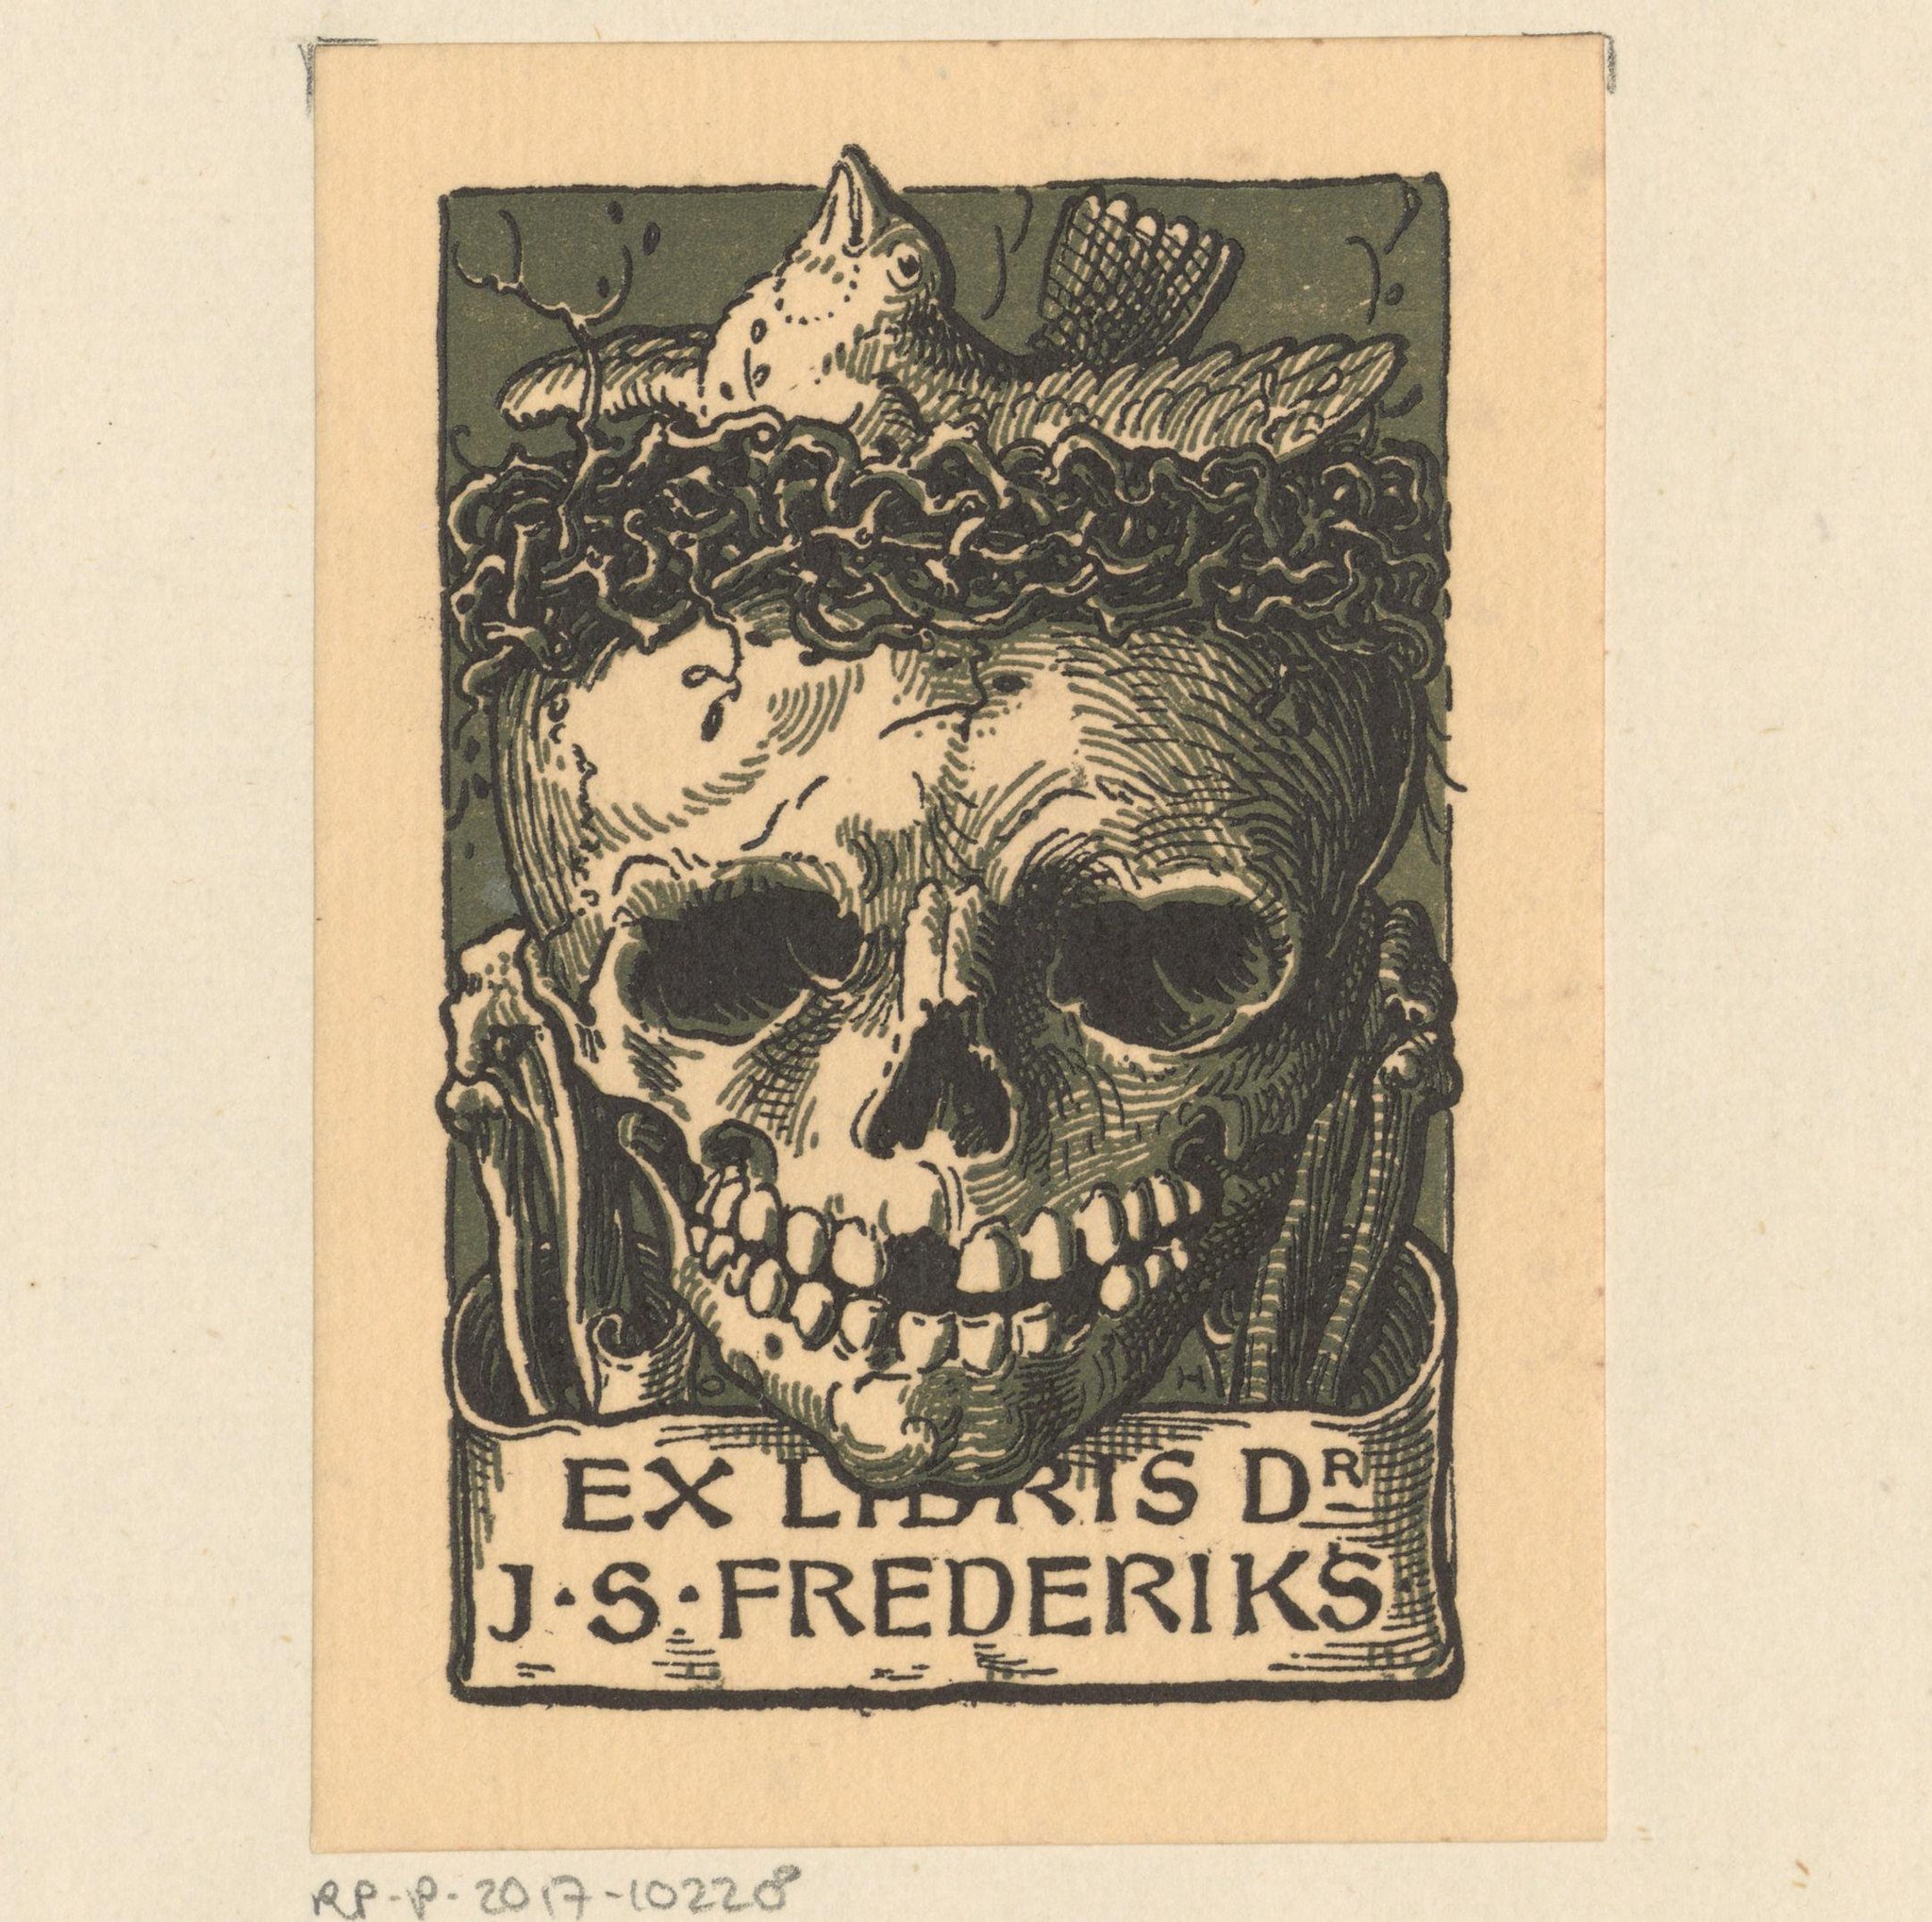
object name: bookplate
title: Ex libris van J.S. Frederiks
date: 1904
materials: paper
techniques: printing block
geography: austria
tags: (human) skull, birds